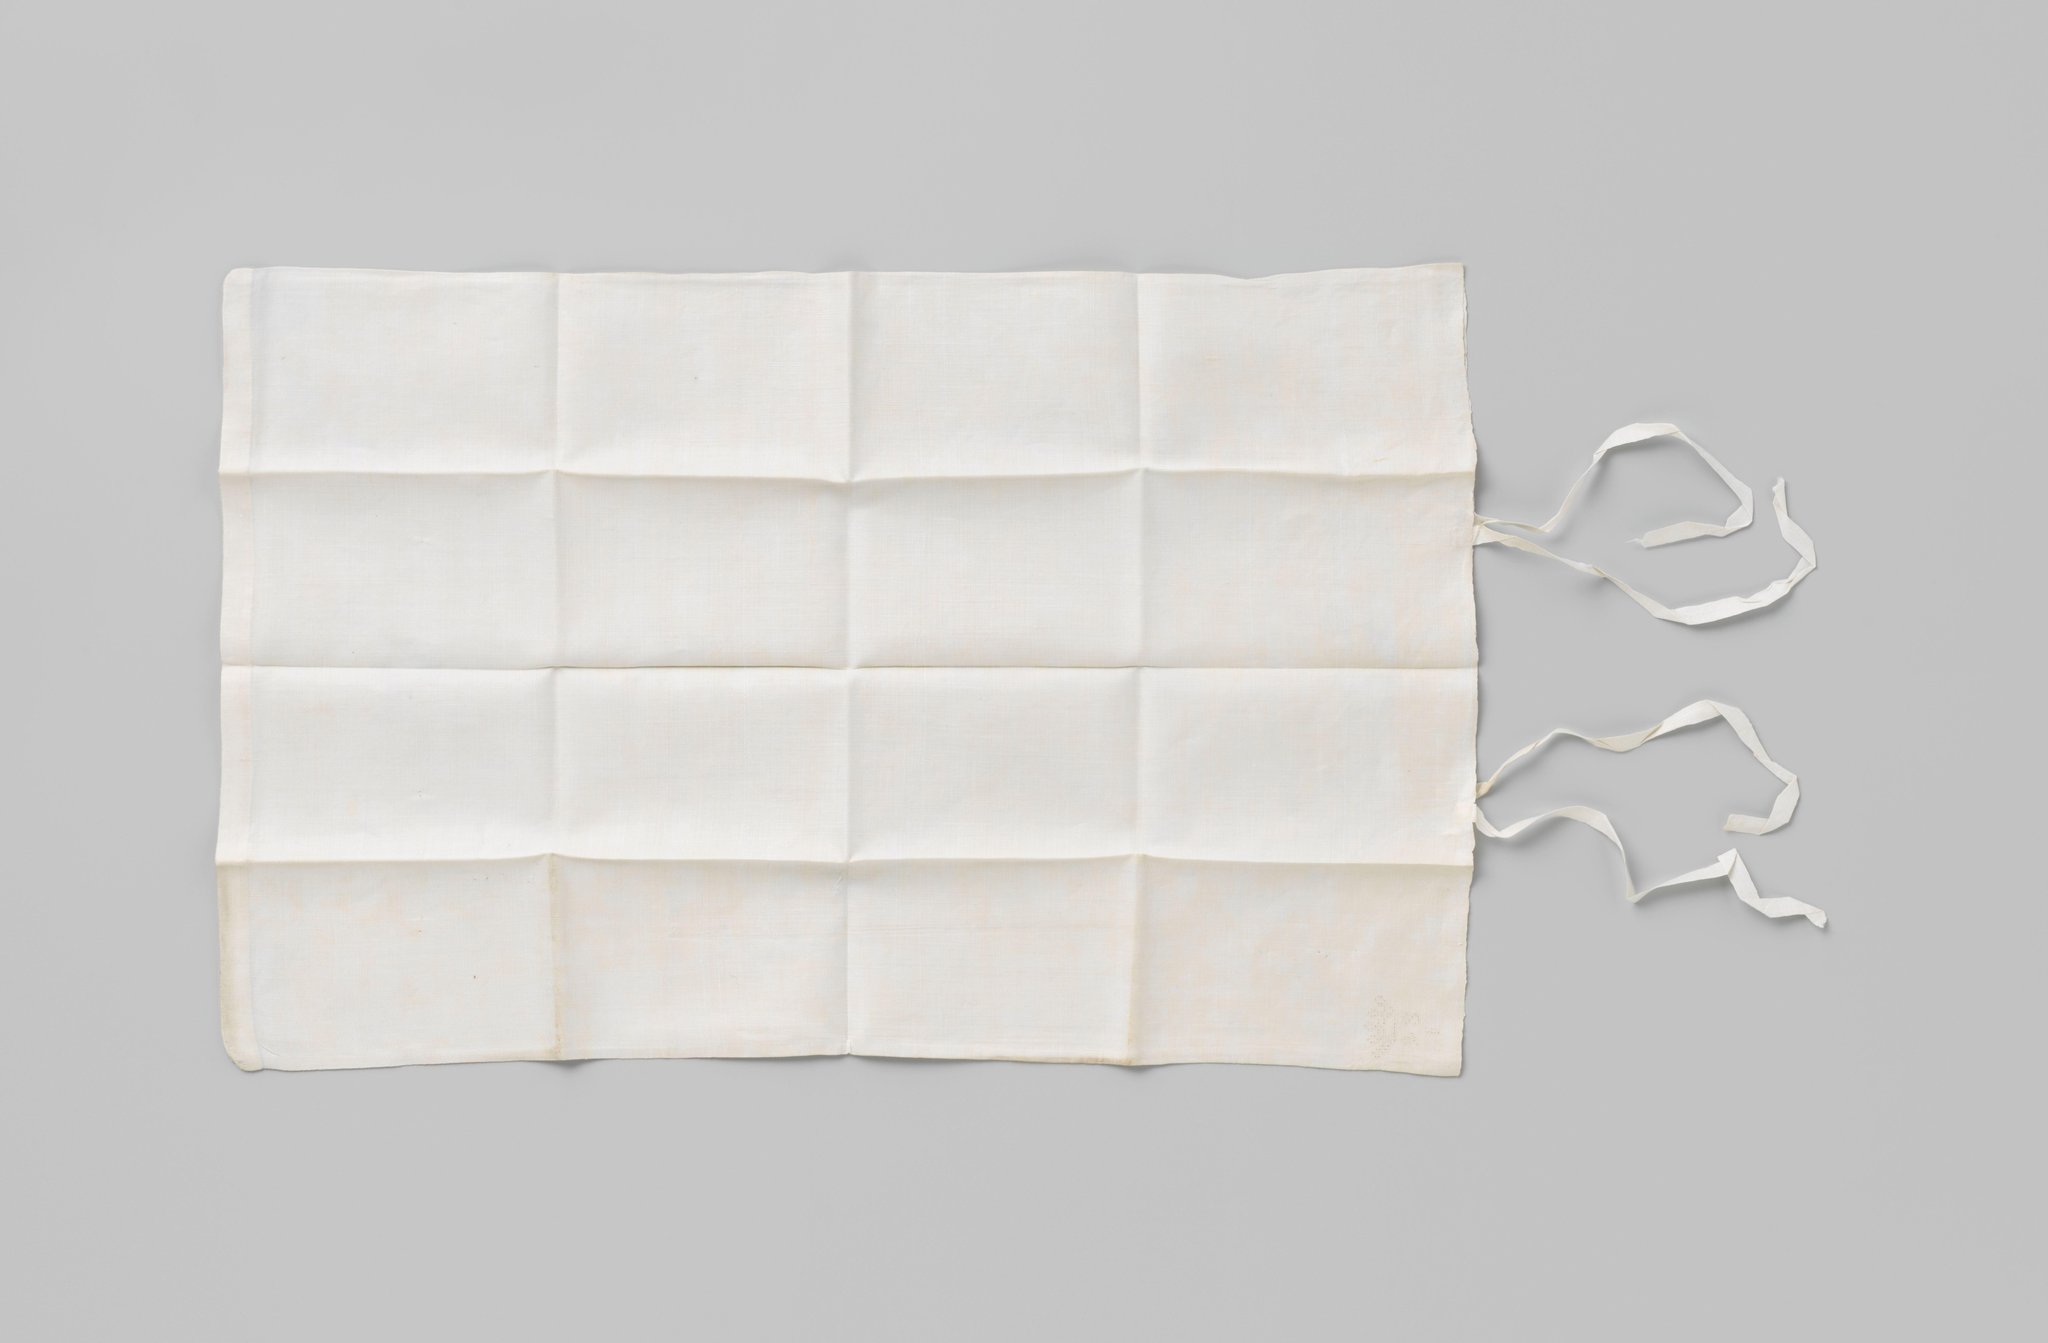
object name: lendensloop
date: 1692-1735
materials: linen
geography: northern netherlands